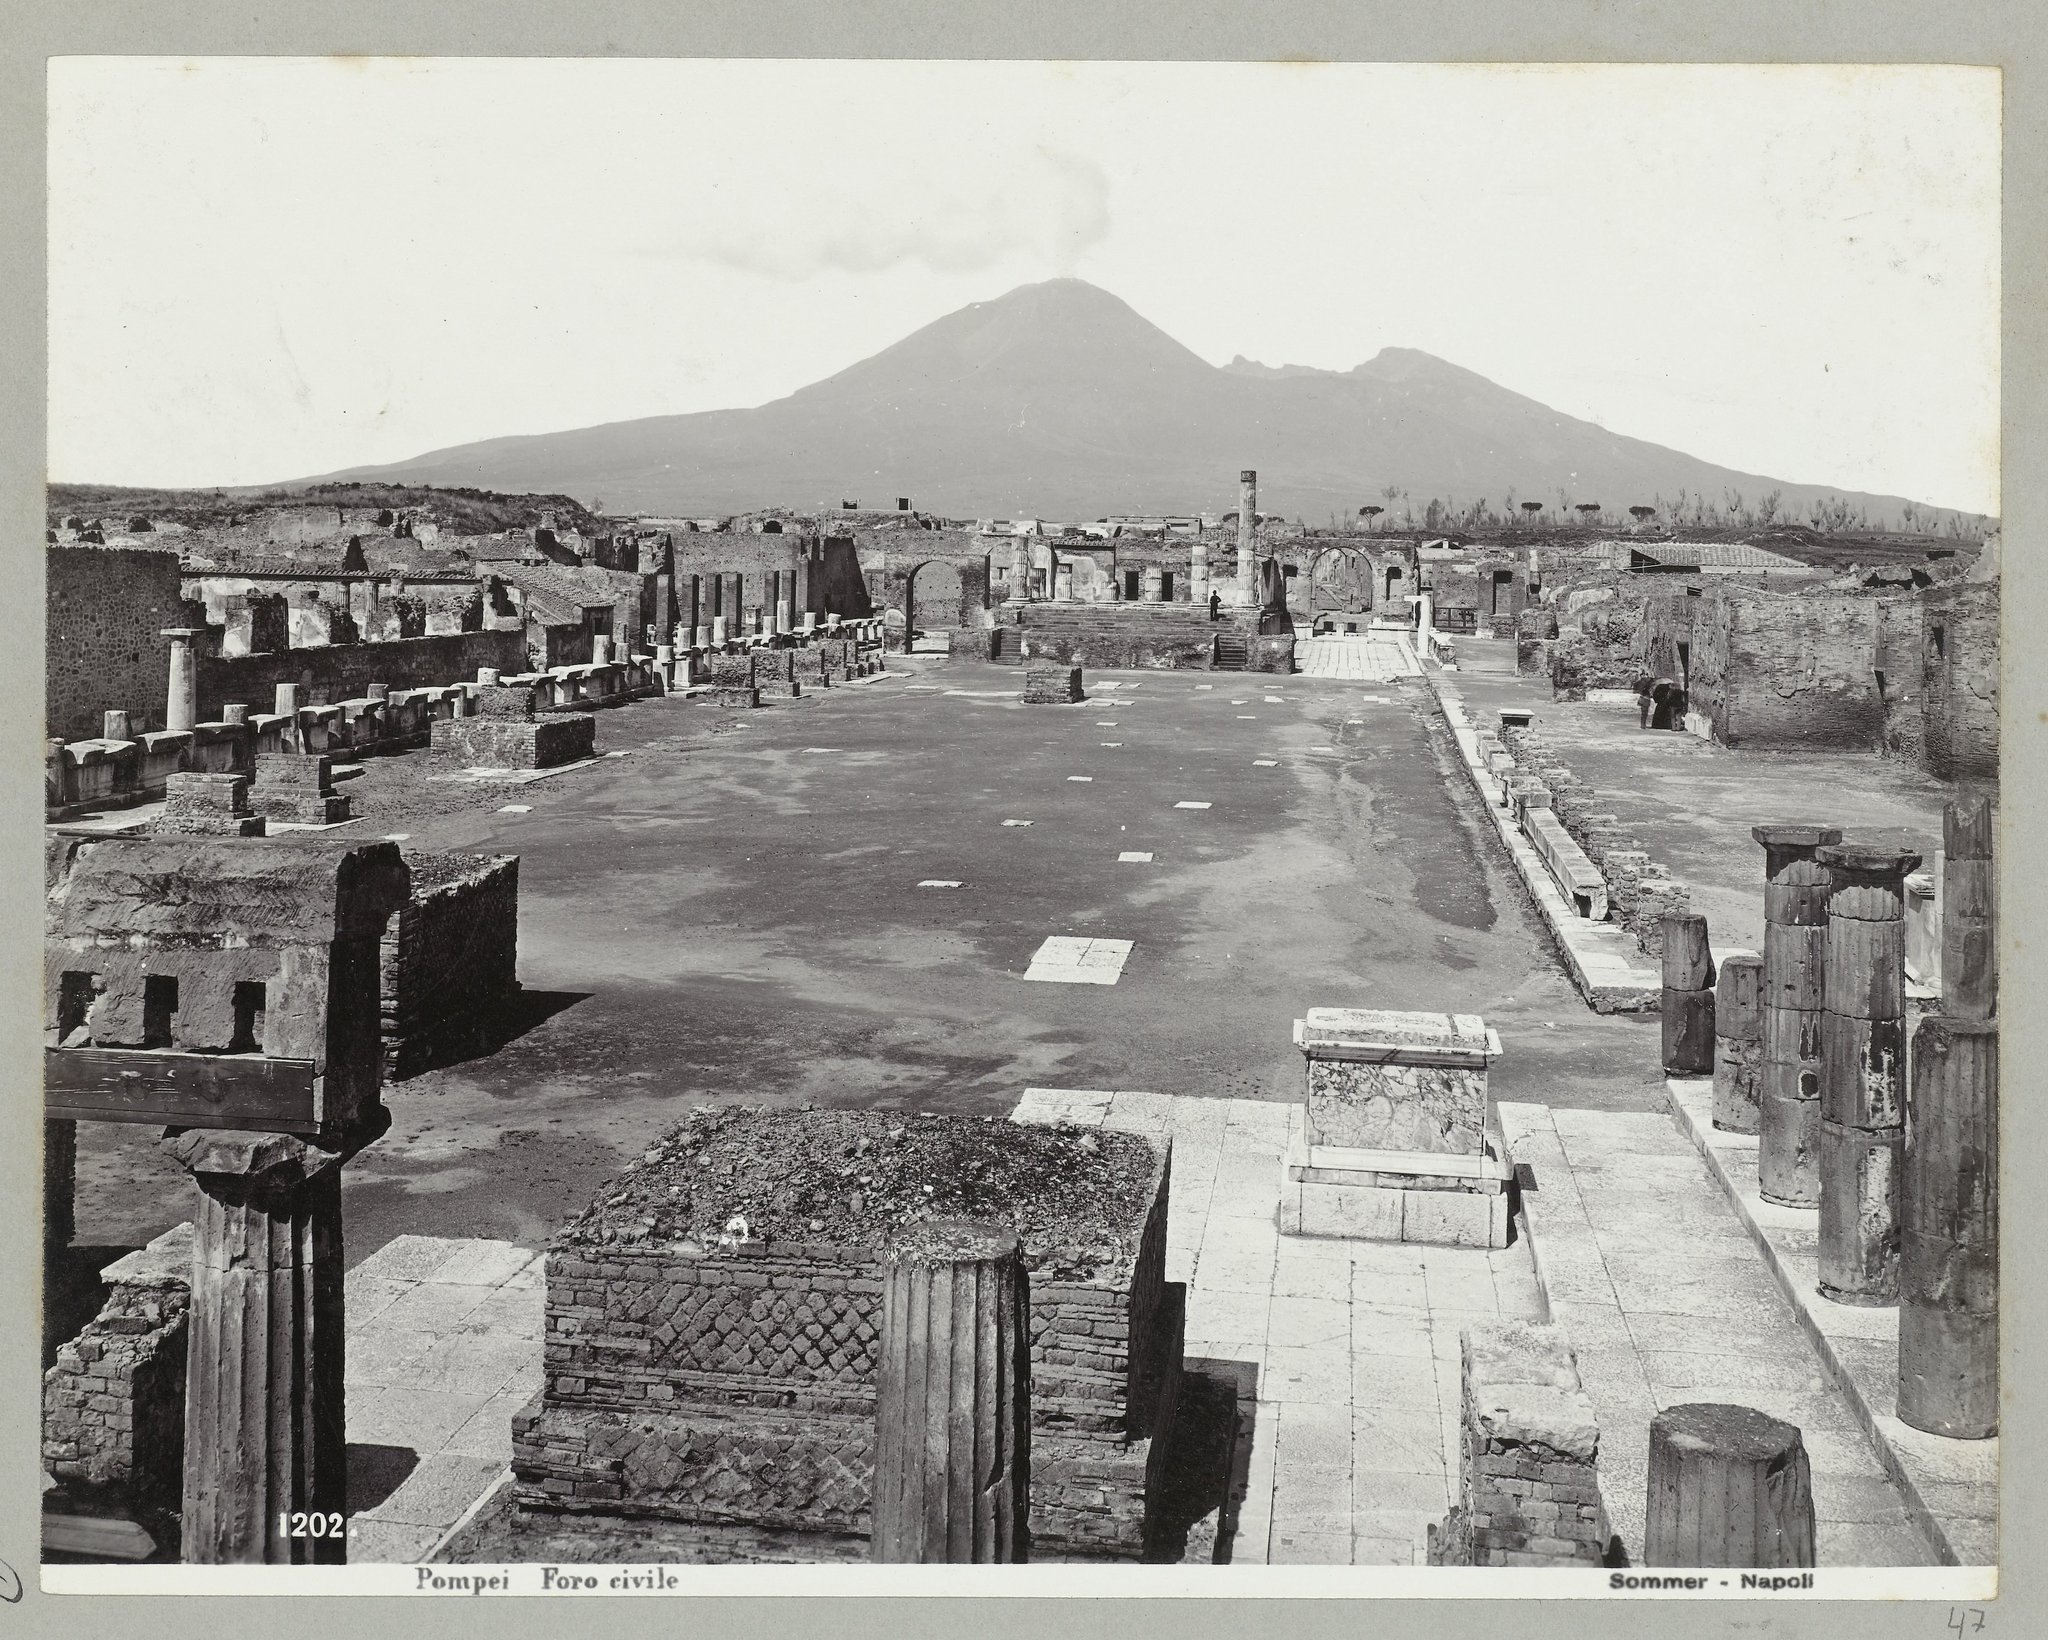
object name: photograph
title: Pompeï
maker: giorgio sommer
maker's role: fotograaf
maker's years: 1834-1914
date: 1888-1903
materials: cardboard, photographic support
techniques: albumen print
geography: netherlands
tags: pompeii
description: Opgraving van het burgerlijk forum in Pompeï met op de achtergrond een rokende Vesuvius.